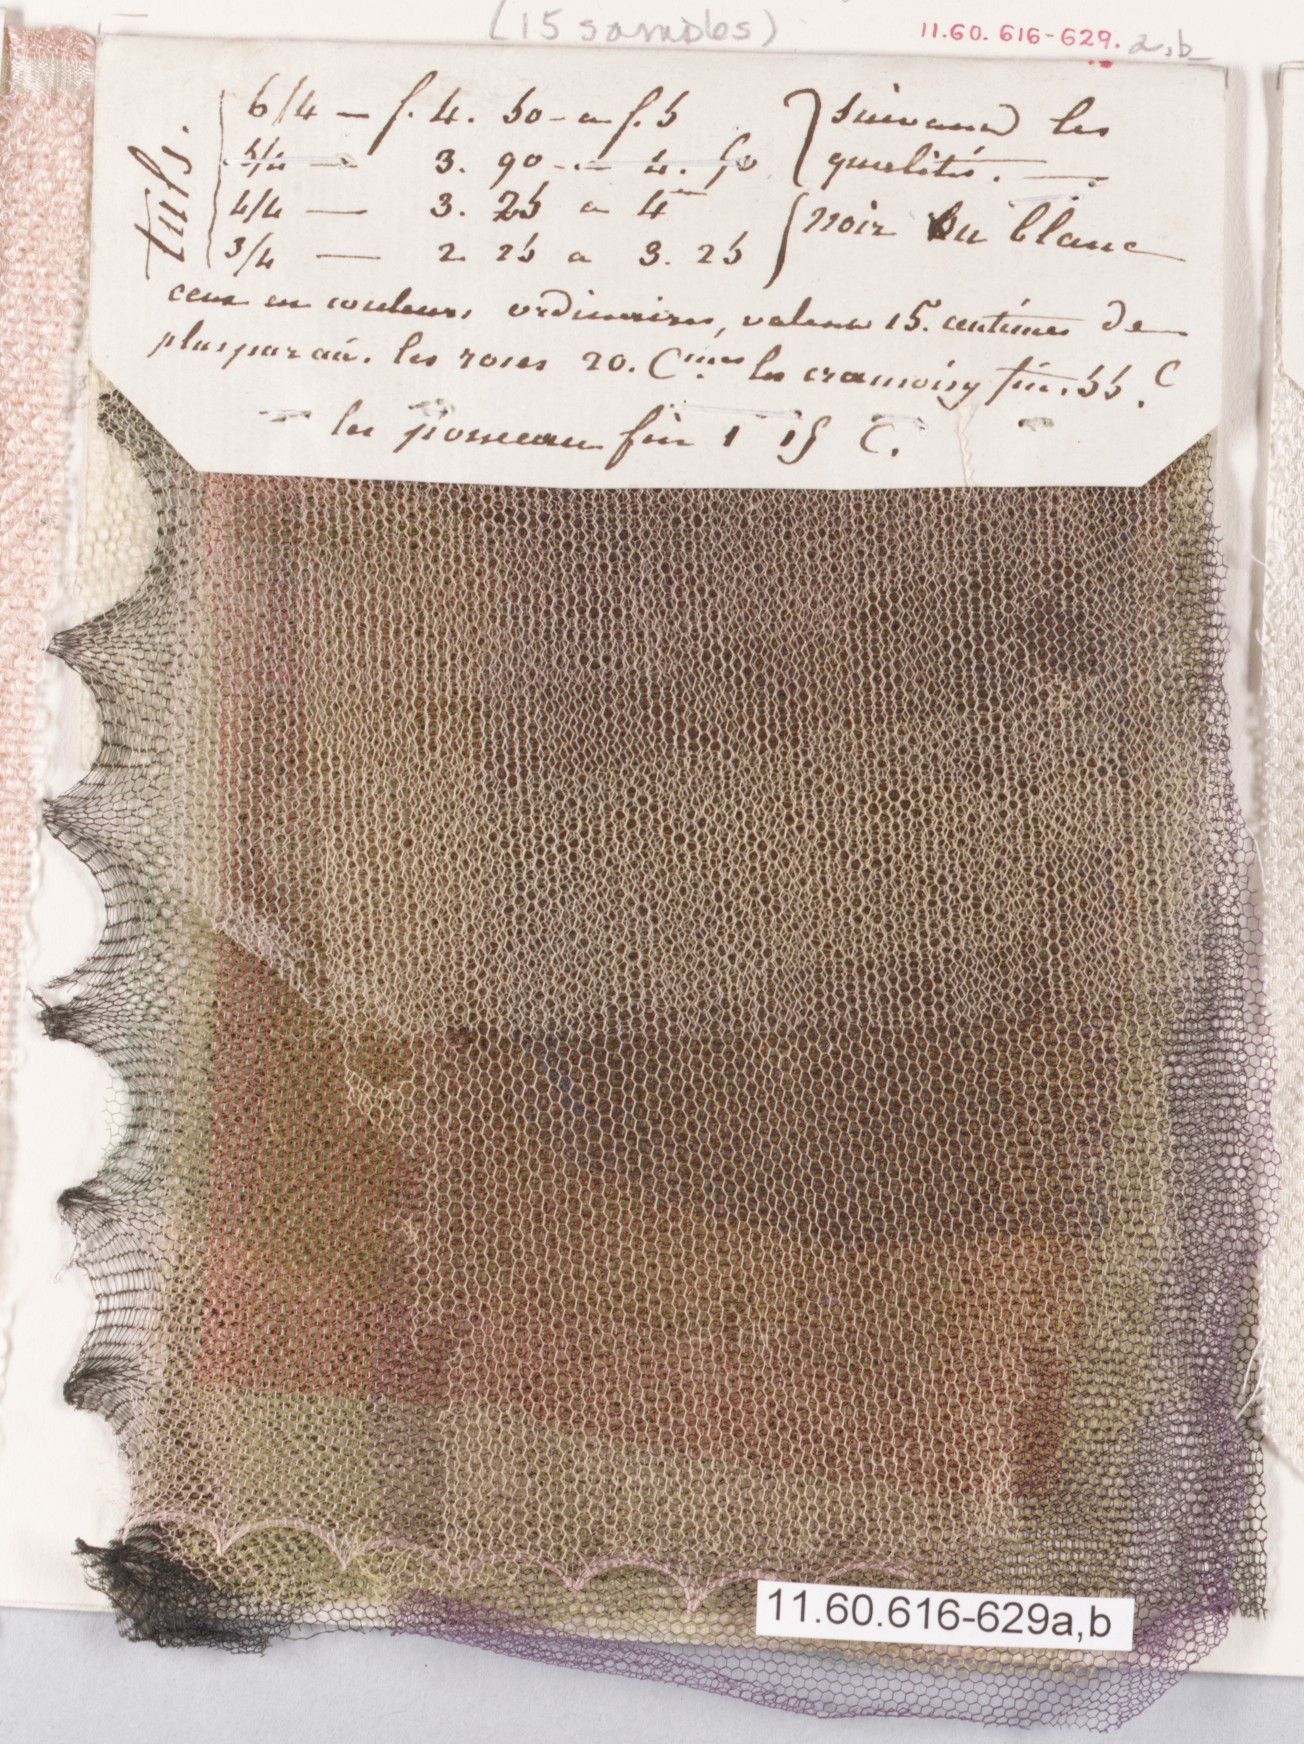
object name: sample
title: Samples (14)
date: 1801-1833